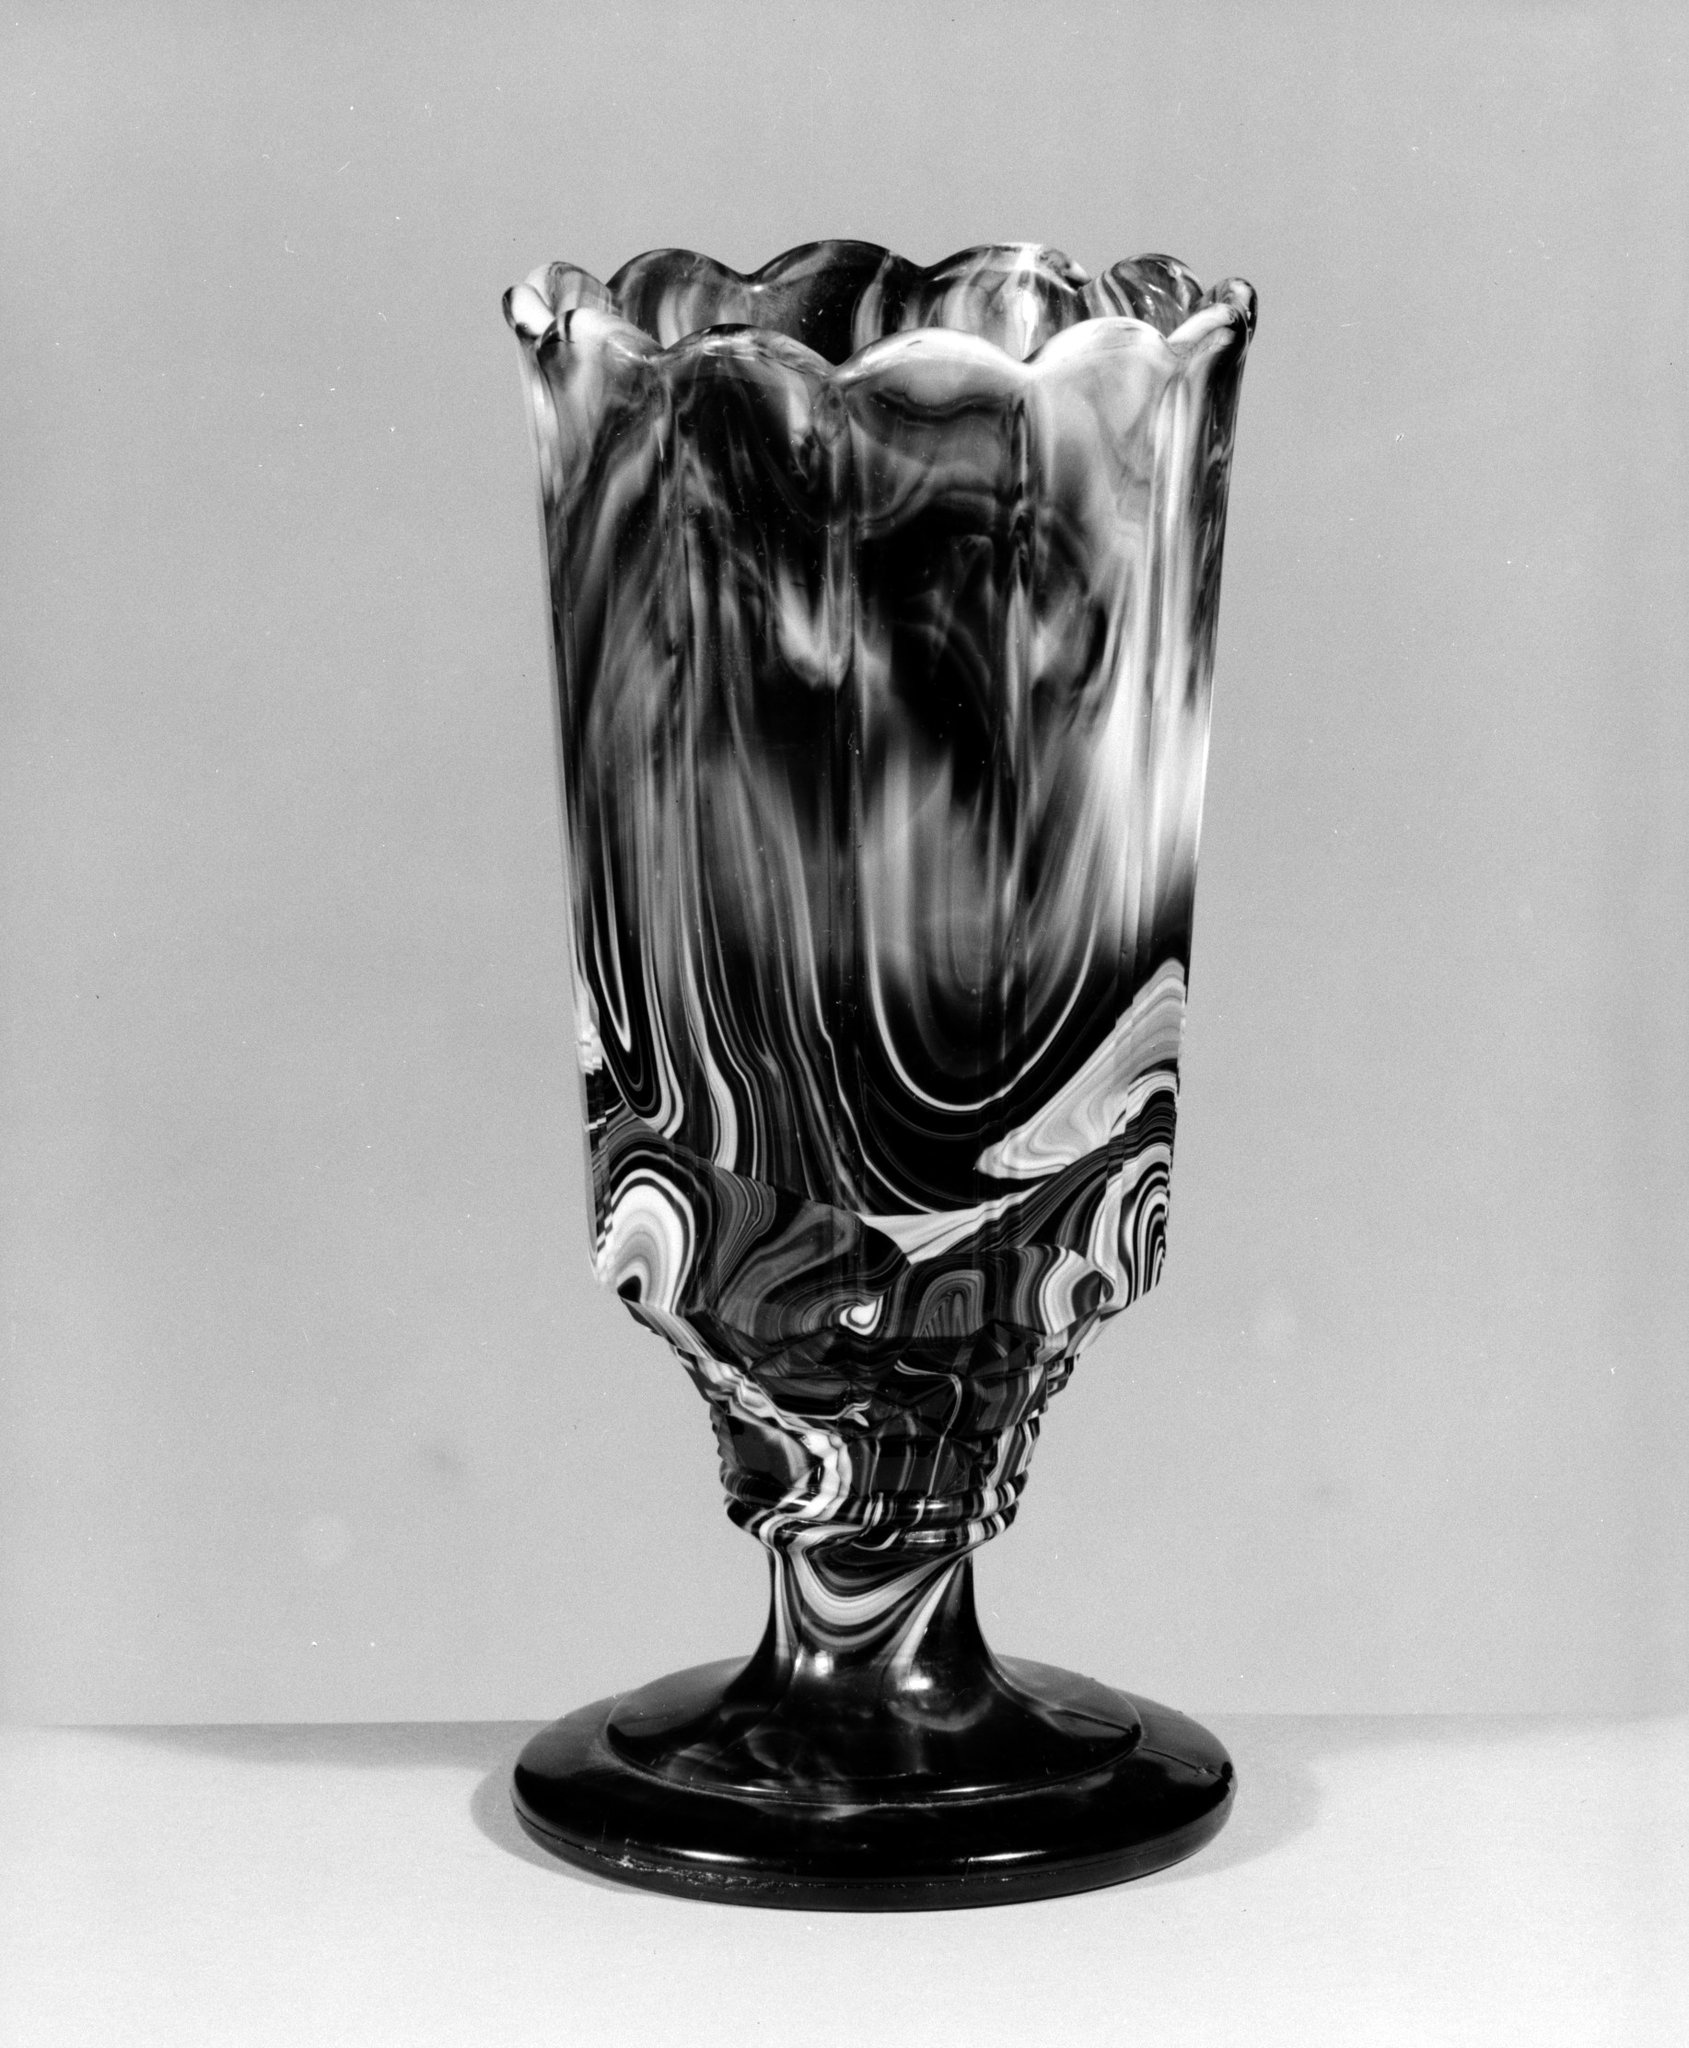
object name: celery vase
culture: american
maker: challinor, taylor and company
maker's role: maker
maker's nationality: american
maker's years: 1866-1891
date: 1870-1890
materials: glass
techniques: pressed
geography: united states